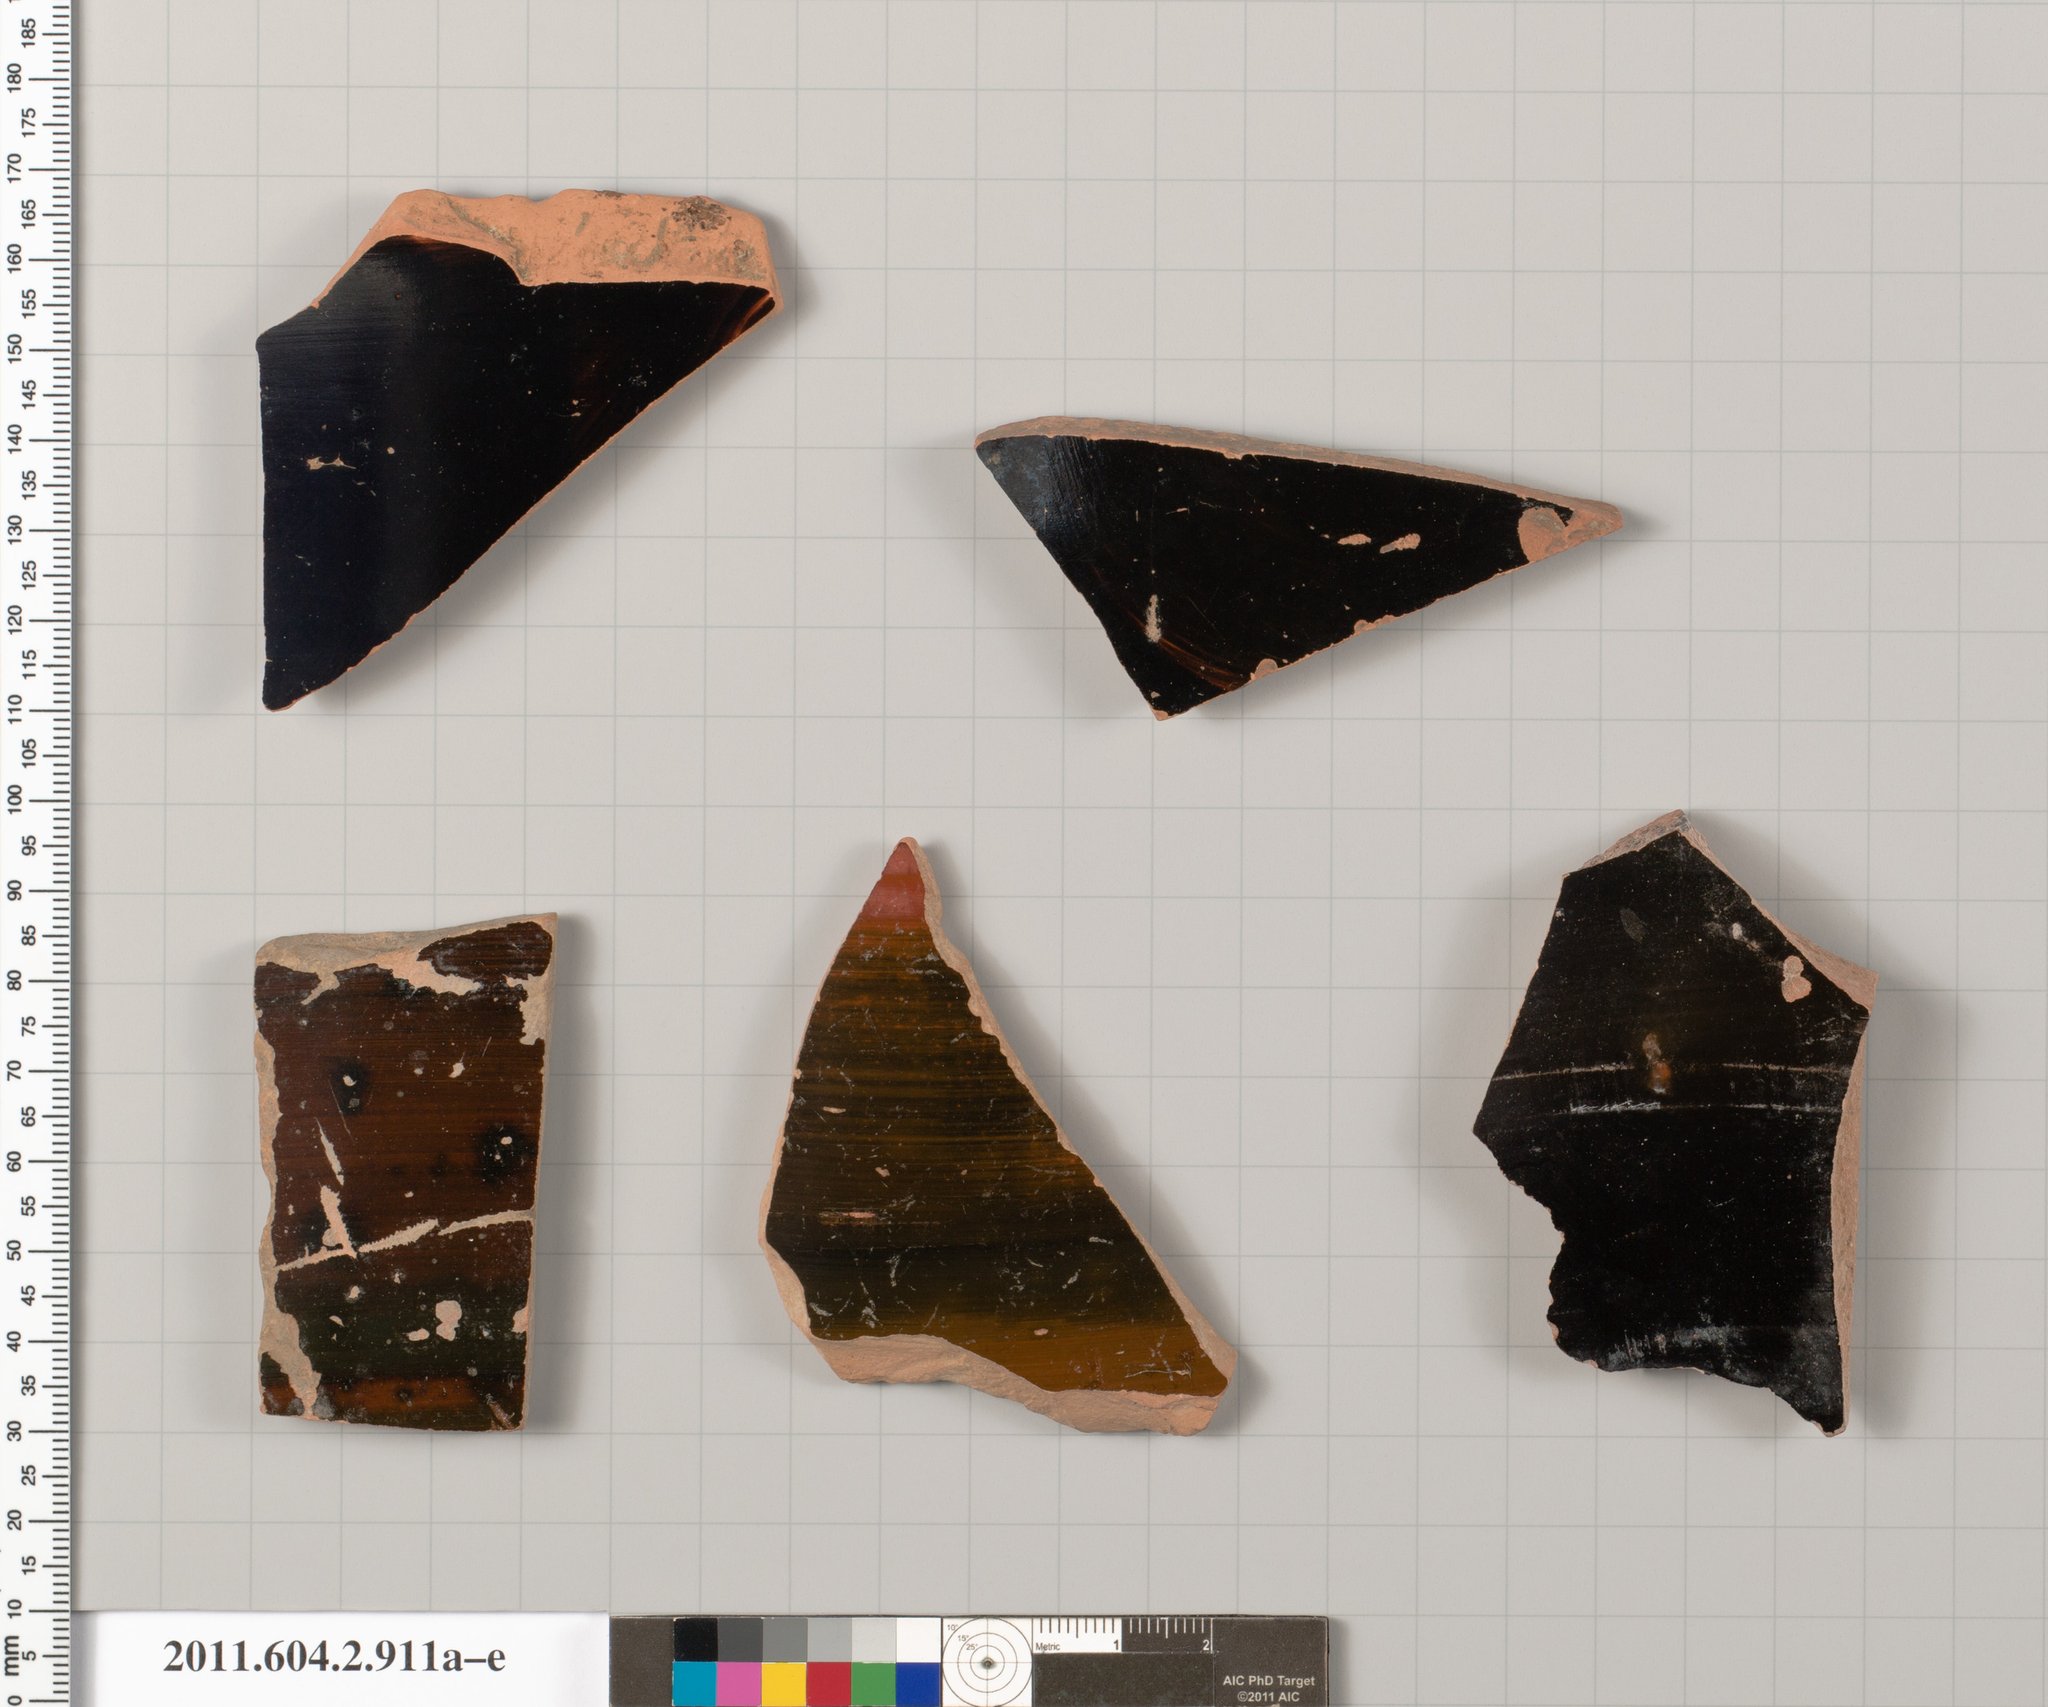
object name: bell krater fragment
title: Terracotta fragments of bell-kraters (bowls for mixing wine and water)?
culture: greek, attic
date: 450-401 BCE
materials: terracotta